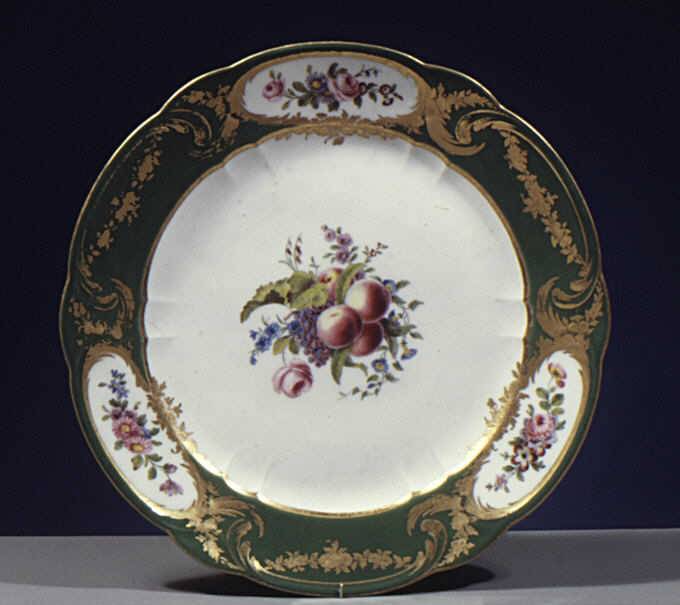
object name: plate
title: Plate (assiette à palmes) (1 of 102) (part of a service)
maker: sèvres manufactory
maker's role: manufactory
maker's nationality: french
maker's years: 1740-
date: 1787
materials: soft paste porcelain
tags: fruit,grapes,flowers